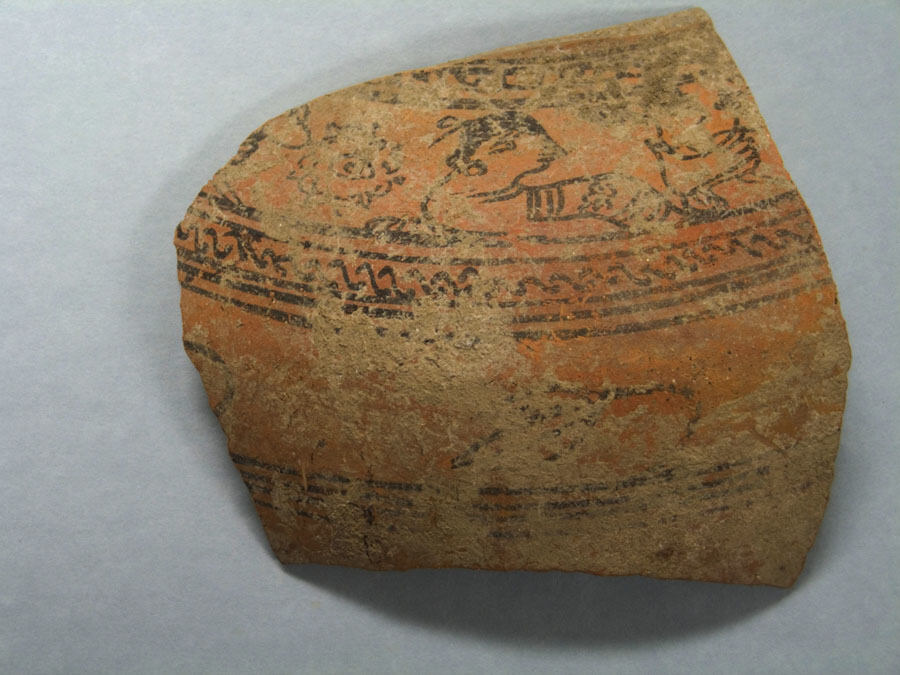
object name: shard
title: Shard: Shoulder of Vessel with Profile of Offerer with Flower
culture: pakistani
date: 301-500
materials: terracotta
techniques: painting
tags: gandhara